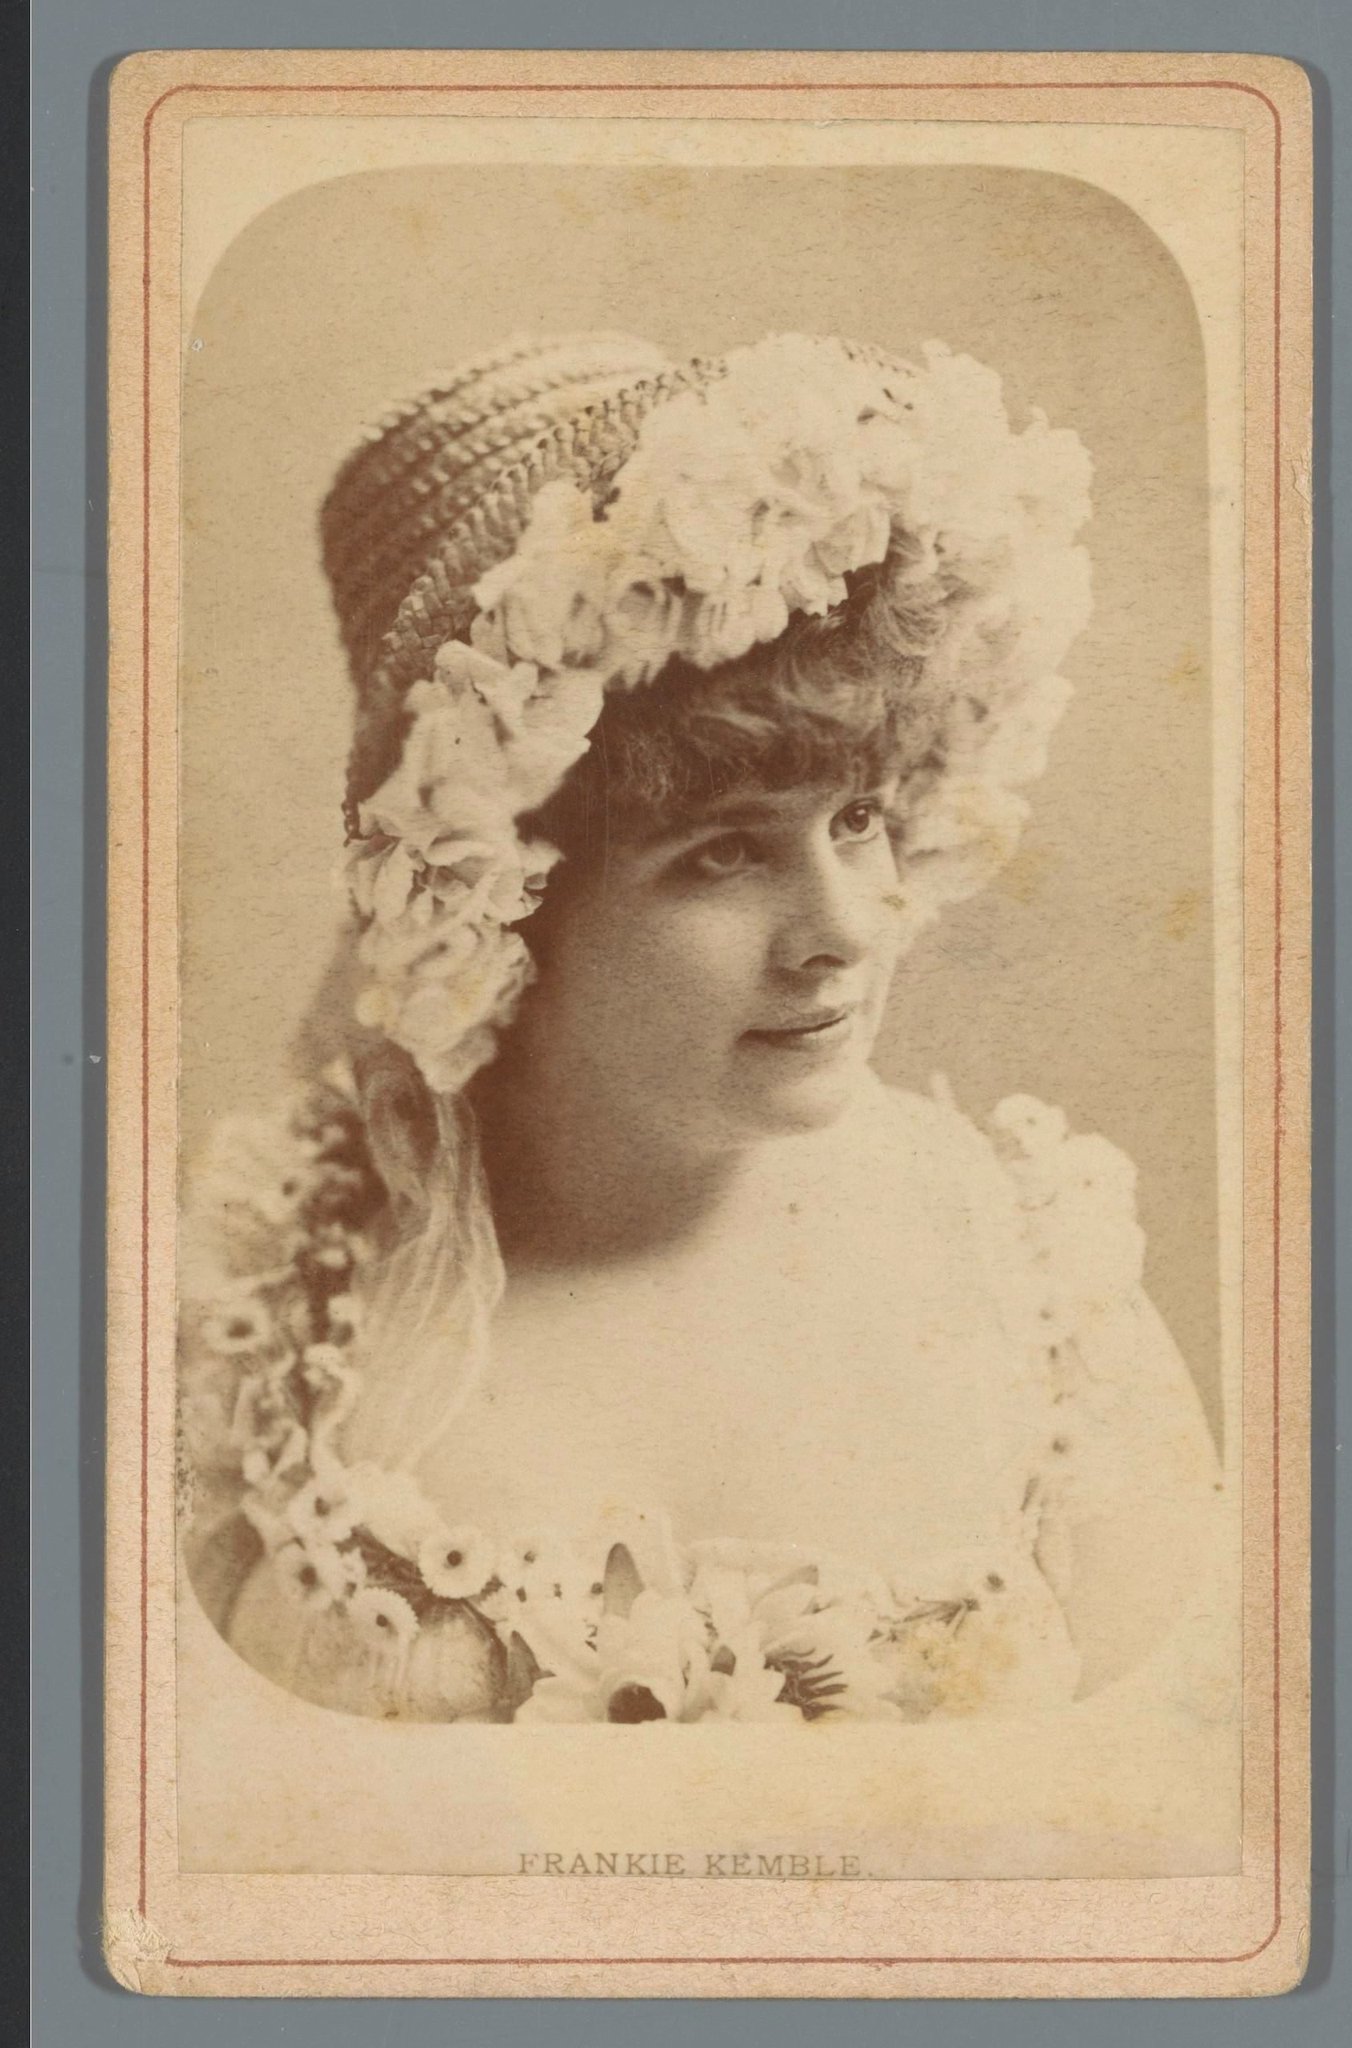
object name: carte de visite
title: Portret van Frankie Kemble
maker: paul henri jean reynet de la rue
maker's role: boekhandelaar, drukkerij, fotograaf, lijstenmaker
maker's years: 1839-1927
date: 1857-1885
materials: cardboard, paper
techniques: albumen print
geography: amsterdam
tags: historical persons - bb - woman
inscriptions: inscription: ‘Inrichting voor Photografie./ VAN/ P.H.J. REYNET DE LA RUE,/ Muziek=, Boek=, Photographie=, Papierhandel enz./ Utrechtschestraat 35. Amsterdam./ Photografeert Gebouwen, Groepen,/ Portretten enz. (bij ieder aan huis), zoowel binnen/ als buiten Amsterdam. Maakt VERGROOTINGEN en COPIËN/ van Photografiën, Teekeningen, Gravures, Schilderijen enz./ Verkleiningen van af 25 stuks voor 60 Ct./ LIJSTENFABRIEK./ ENCADREMENTEN./ BOEKDRUKKERIJ./ BOEKBINDERIJ.’